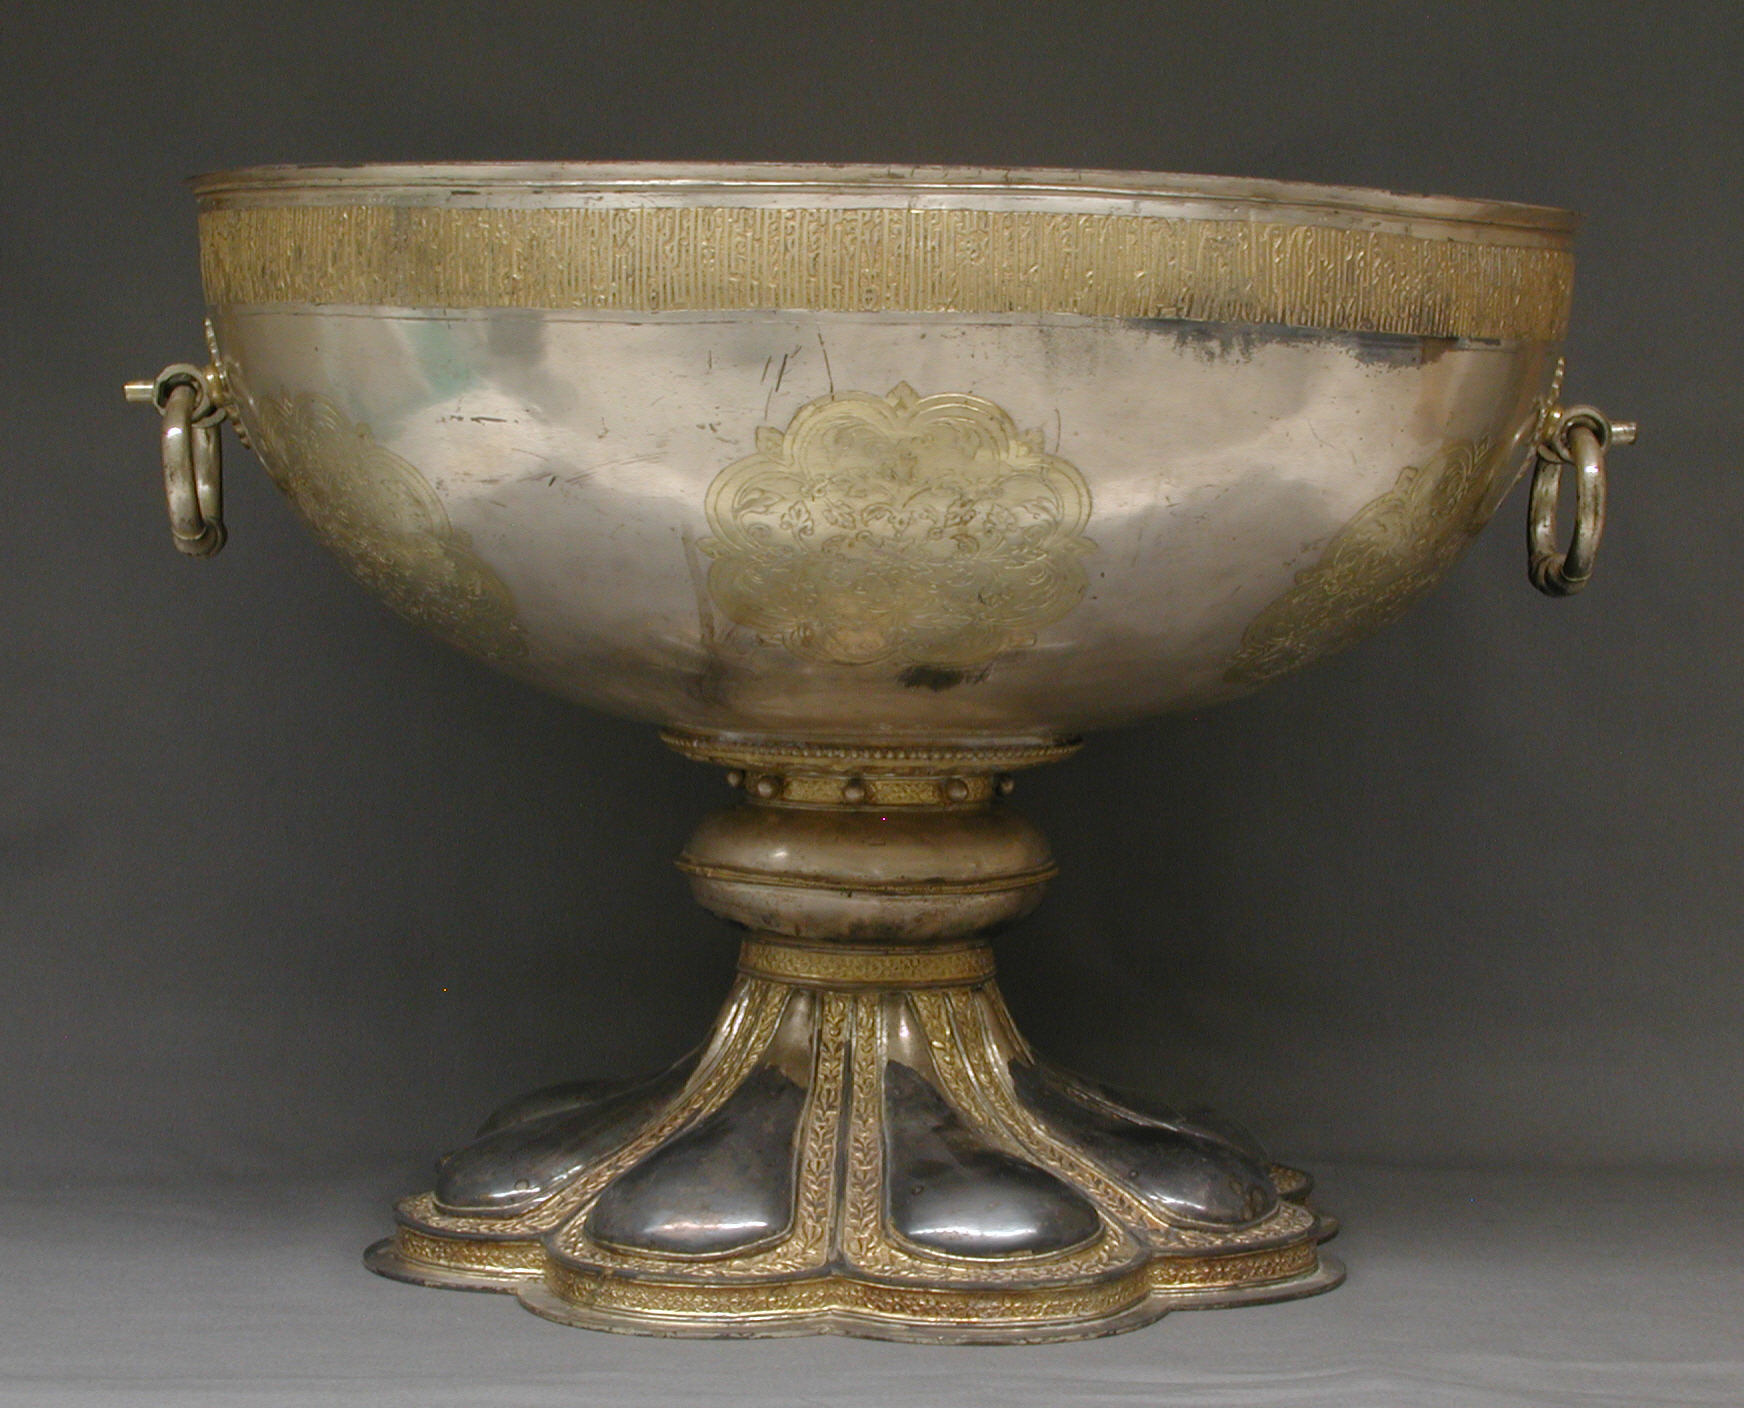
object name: bowl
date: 1801-1900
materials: gilt, silver